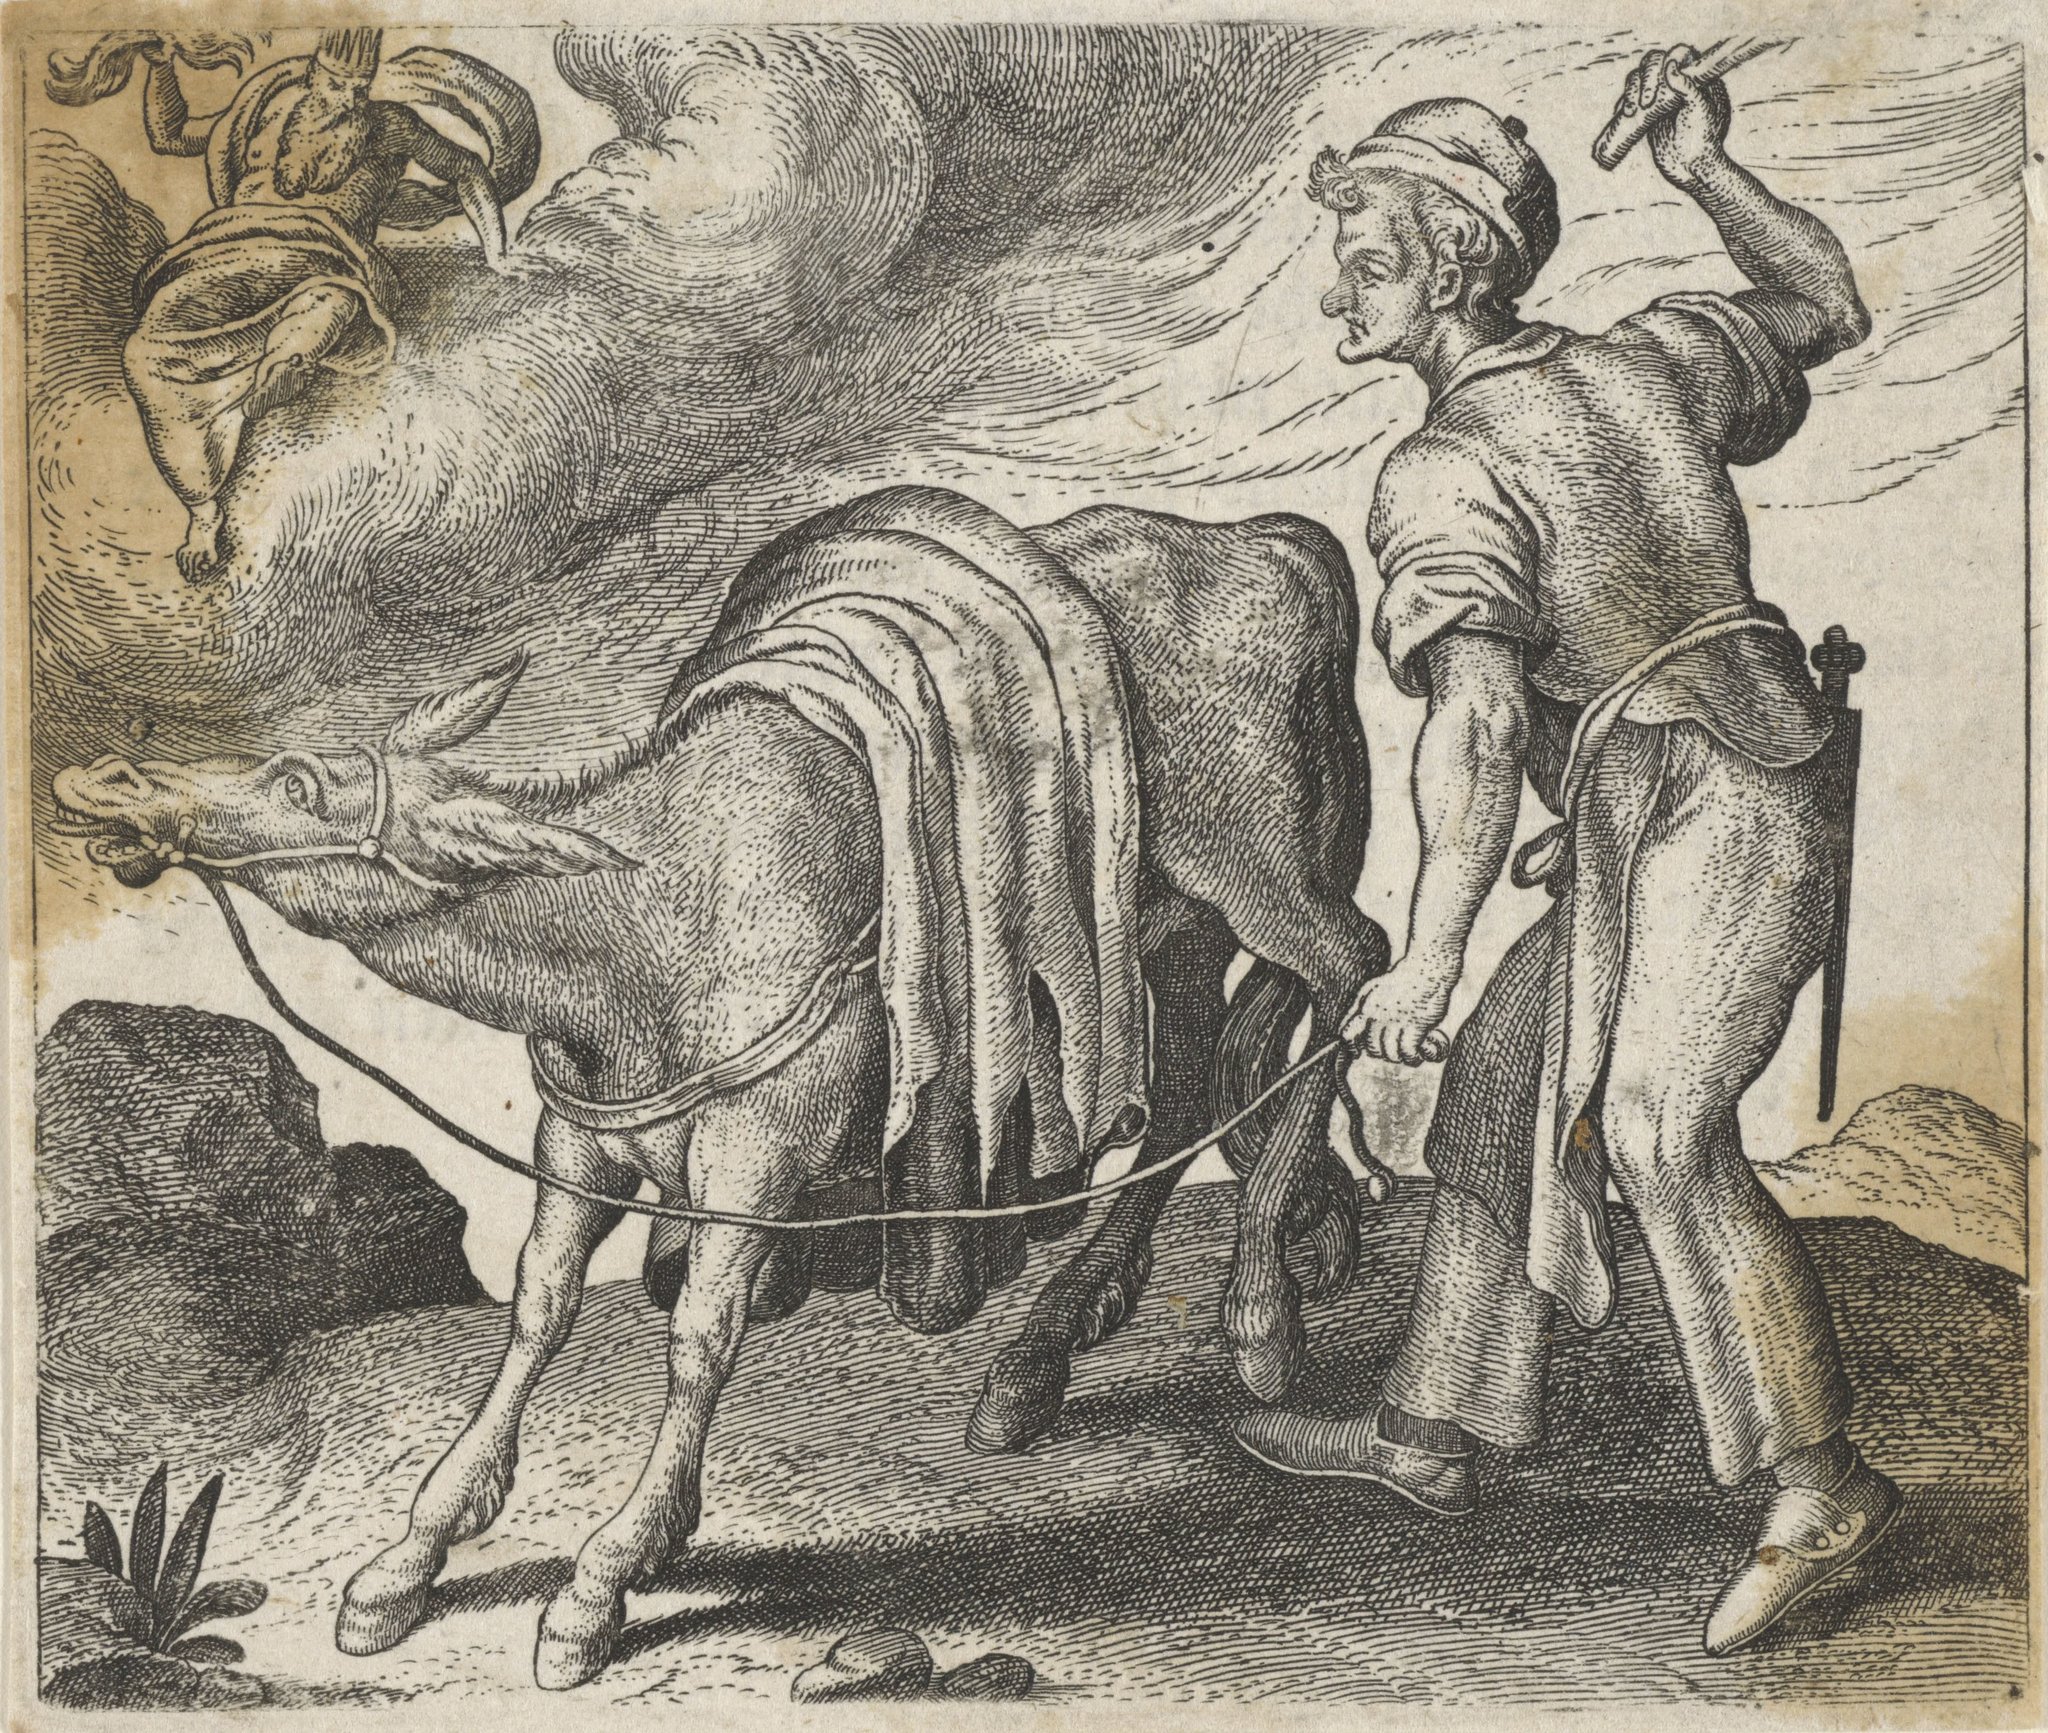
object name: print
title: Fabel van de ezel en zijn drie meesters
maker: aegidius sadeler (ii)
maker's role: draughtsman, print maker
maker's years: 1568-1629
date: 1608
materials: paper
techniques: engraving, etching, letterpress printing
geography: prague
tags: ass, donkey, (story of) jupiter (zeus), hitting at something, fables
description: Een ezel wordt door een man met een knuppel geslagen. In de hemel kijkt Jupiter toe. De fabel beschrijft hoe een ezel niet tevreden is met zijn meester en tot driemaal toe Jupiter vraagt van meester te veranderen. Elke keer krijgt de ezel een slechtere meester. De moraal van het verhaal leert dat men zich moet neerleggen bij zijn lot in het leven.